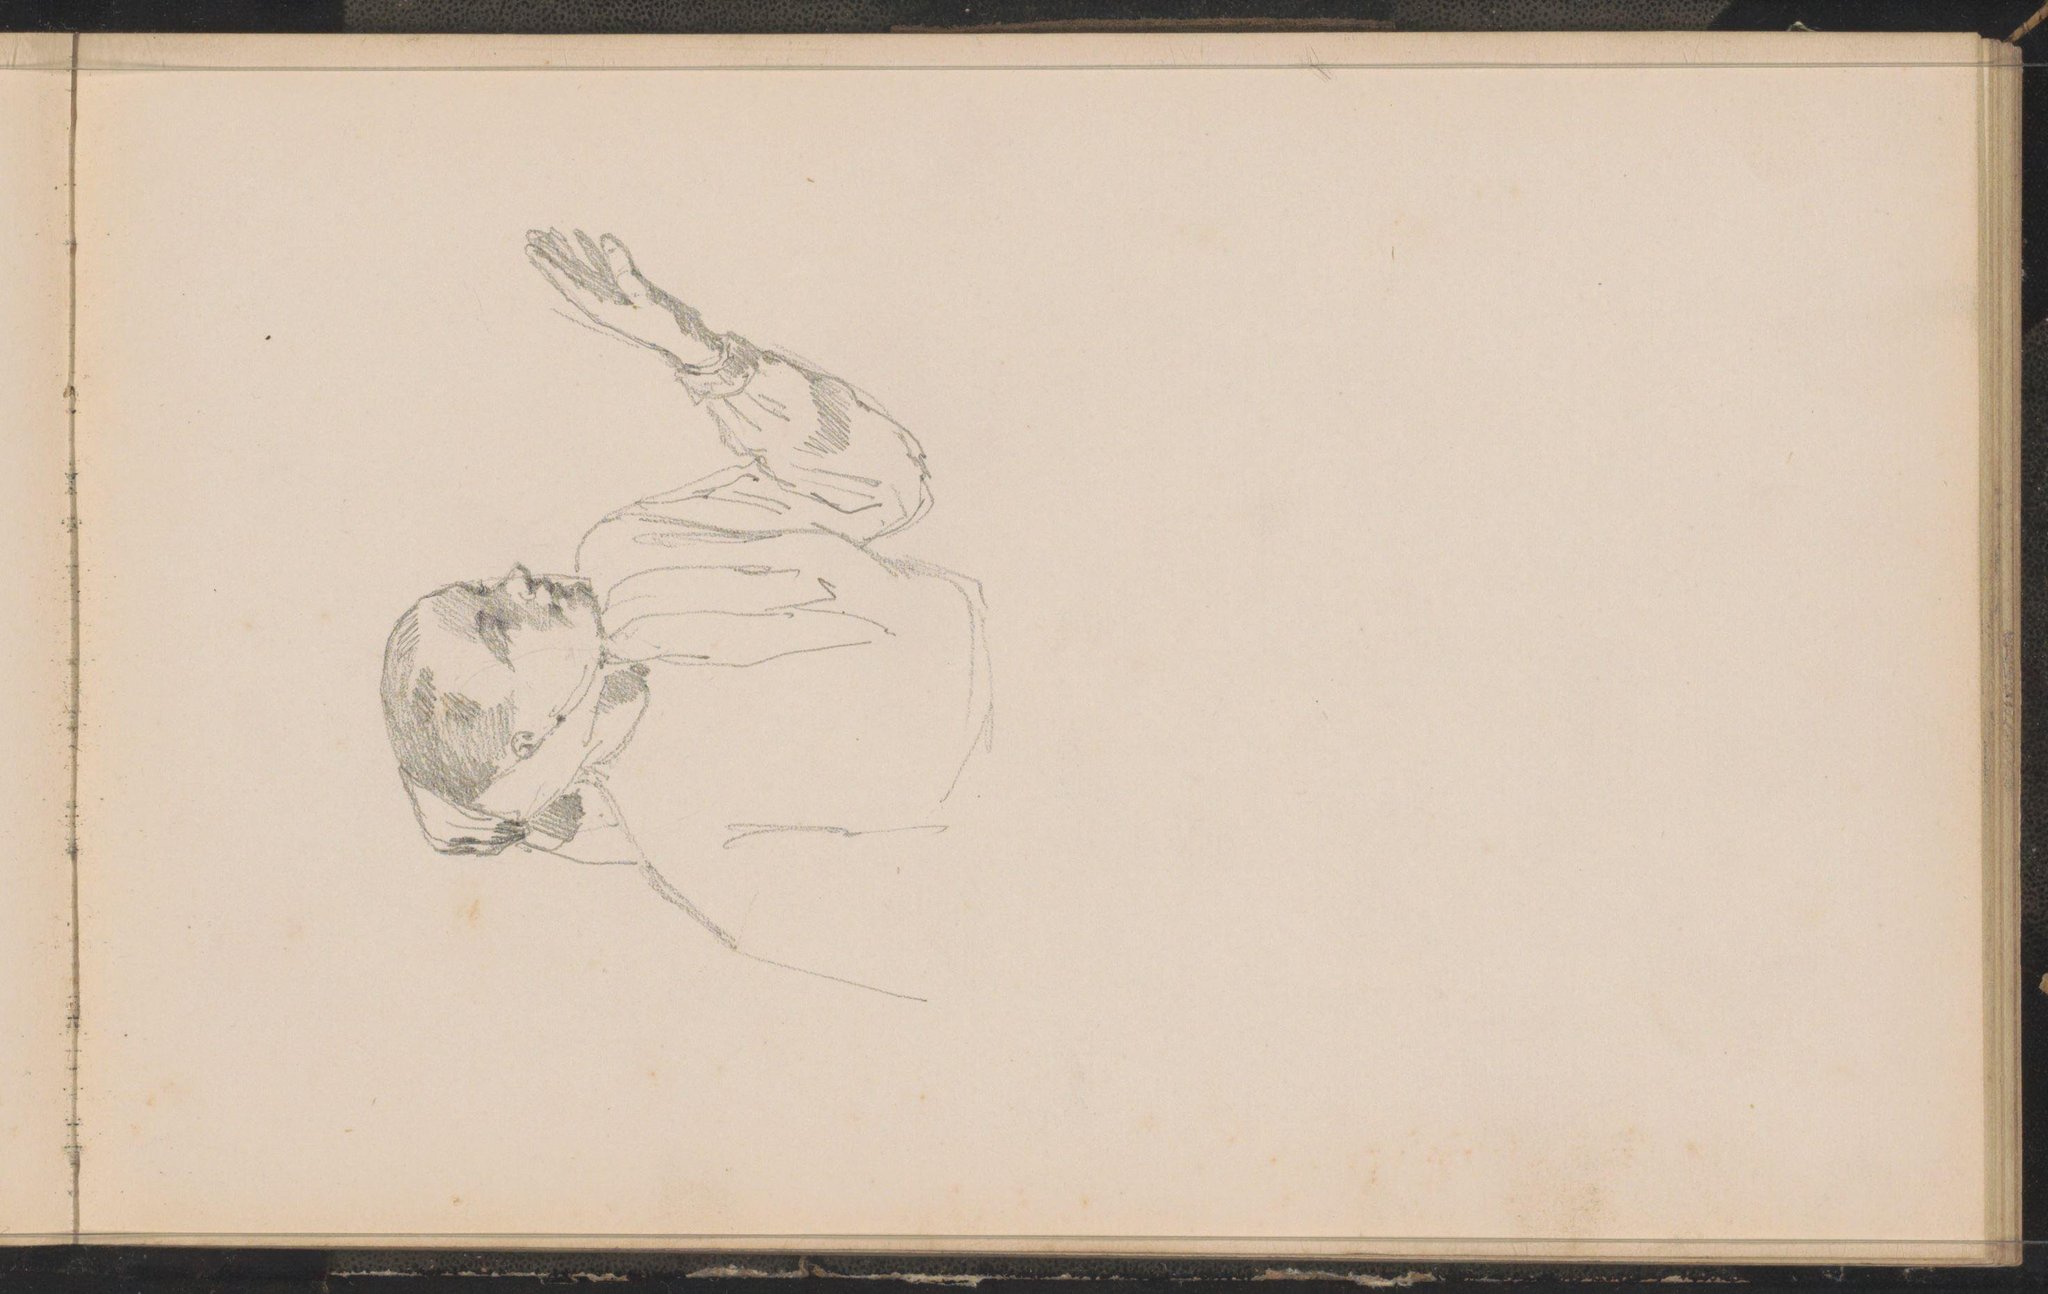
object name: sketchbook leaf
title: Vrouw in klederdracht met opgeheven linkerhand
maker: cornelis springer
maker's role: draughtsman, painter, print maker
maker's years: 1817-1891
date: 1873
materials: paper, pencil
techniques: stumping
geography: netherlands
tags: adult woman, arm or hand held in front of the body, folk costume, regional costume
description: Bovenlichaam van een vrouw in klederdracht met opgeheven linkerhand. Blad 21 uit een schetsboek met 46 bladen.